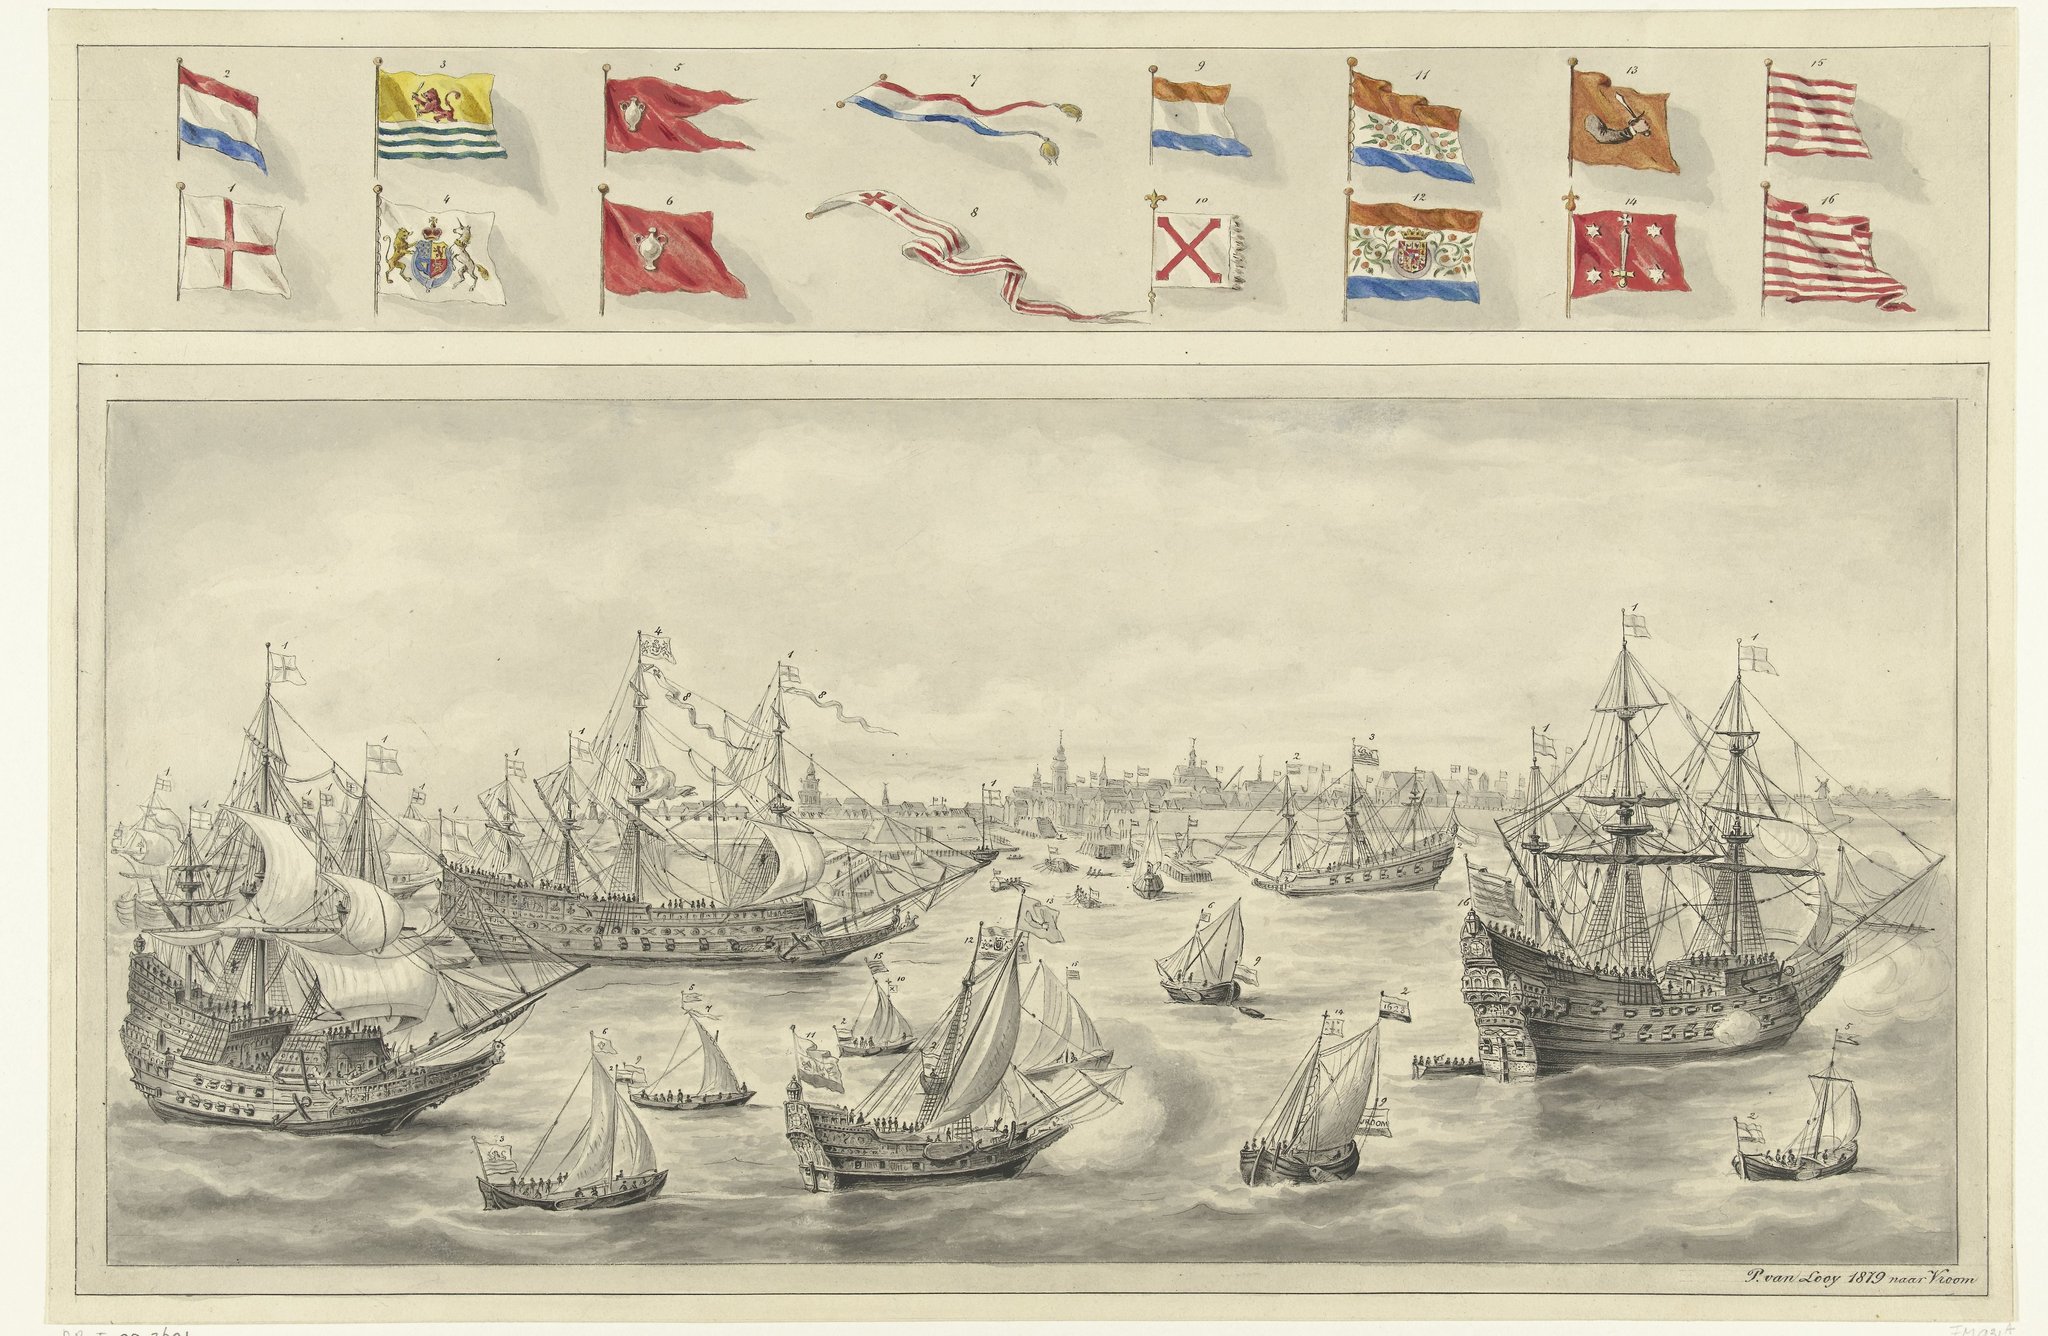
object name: drawing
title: Aankomst van graaf Leicester te Vlissingen, 1585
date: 1879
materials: paper, watercolor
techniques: brush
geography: netherlands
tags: amberg, frederik v (keurvorst van de palts, koning van bohemen), robert dudley (1st earl of leicester), warfare; military affairs (+ naval force), flushing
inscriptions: date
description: Aankomst van de Engelse vloot met Robert Dudley, graaf van Leicester bij Vlissingen, 20 december 1585. Groep van grote en kleine schepen voor de kade, op de achtergrond te stad. Bovenaan in een aparte kader zestien genummerde vlaggen van de afgebeelde schepen. In werkelijkheid is dit een voorstelling van de aankomst van Frederik V van de Palts en Elizabeth Stuart te Vlissingen op 29 april 1613.